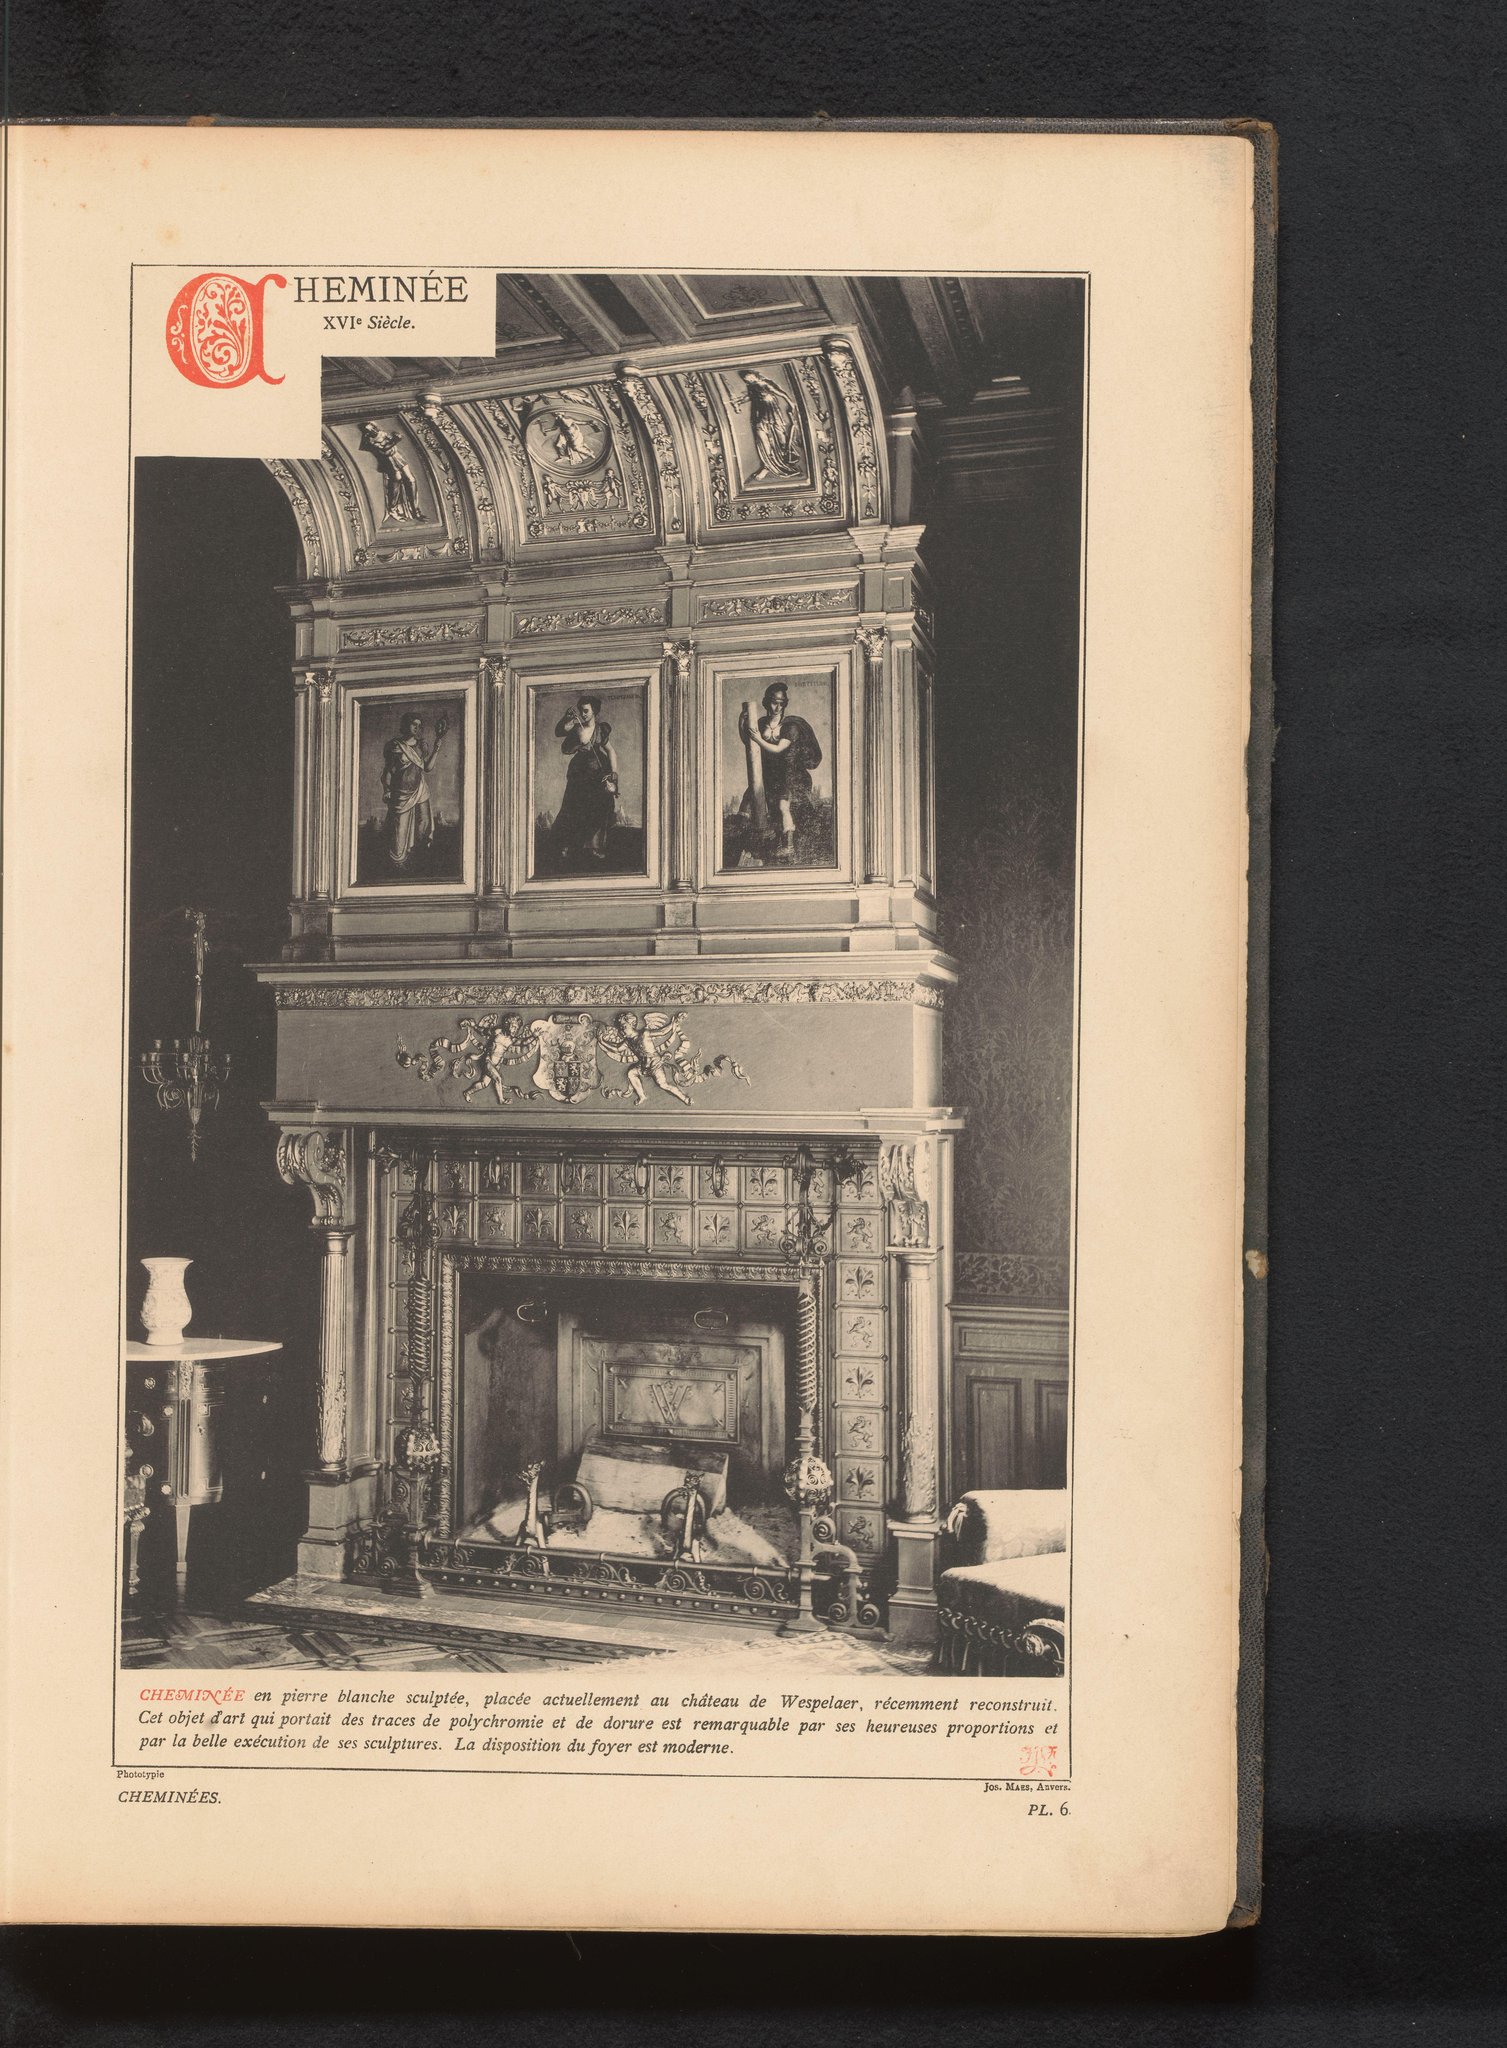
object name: page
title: Cheminée, XVIe Siècle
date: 1881-1889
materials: paper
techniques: photograph, photolithography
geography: antwerp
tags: chimney-piece, mantelpiece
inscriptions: inscription: ‘CHEMINÉES. PL. 6.’, monogram: ‘JJvY’, inscription: ‘CHEMINÉE en pierre (...)’